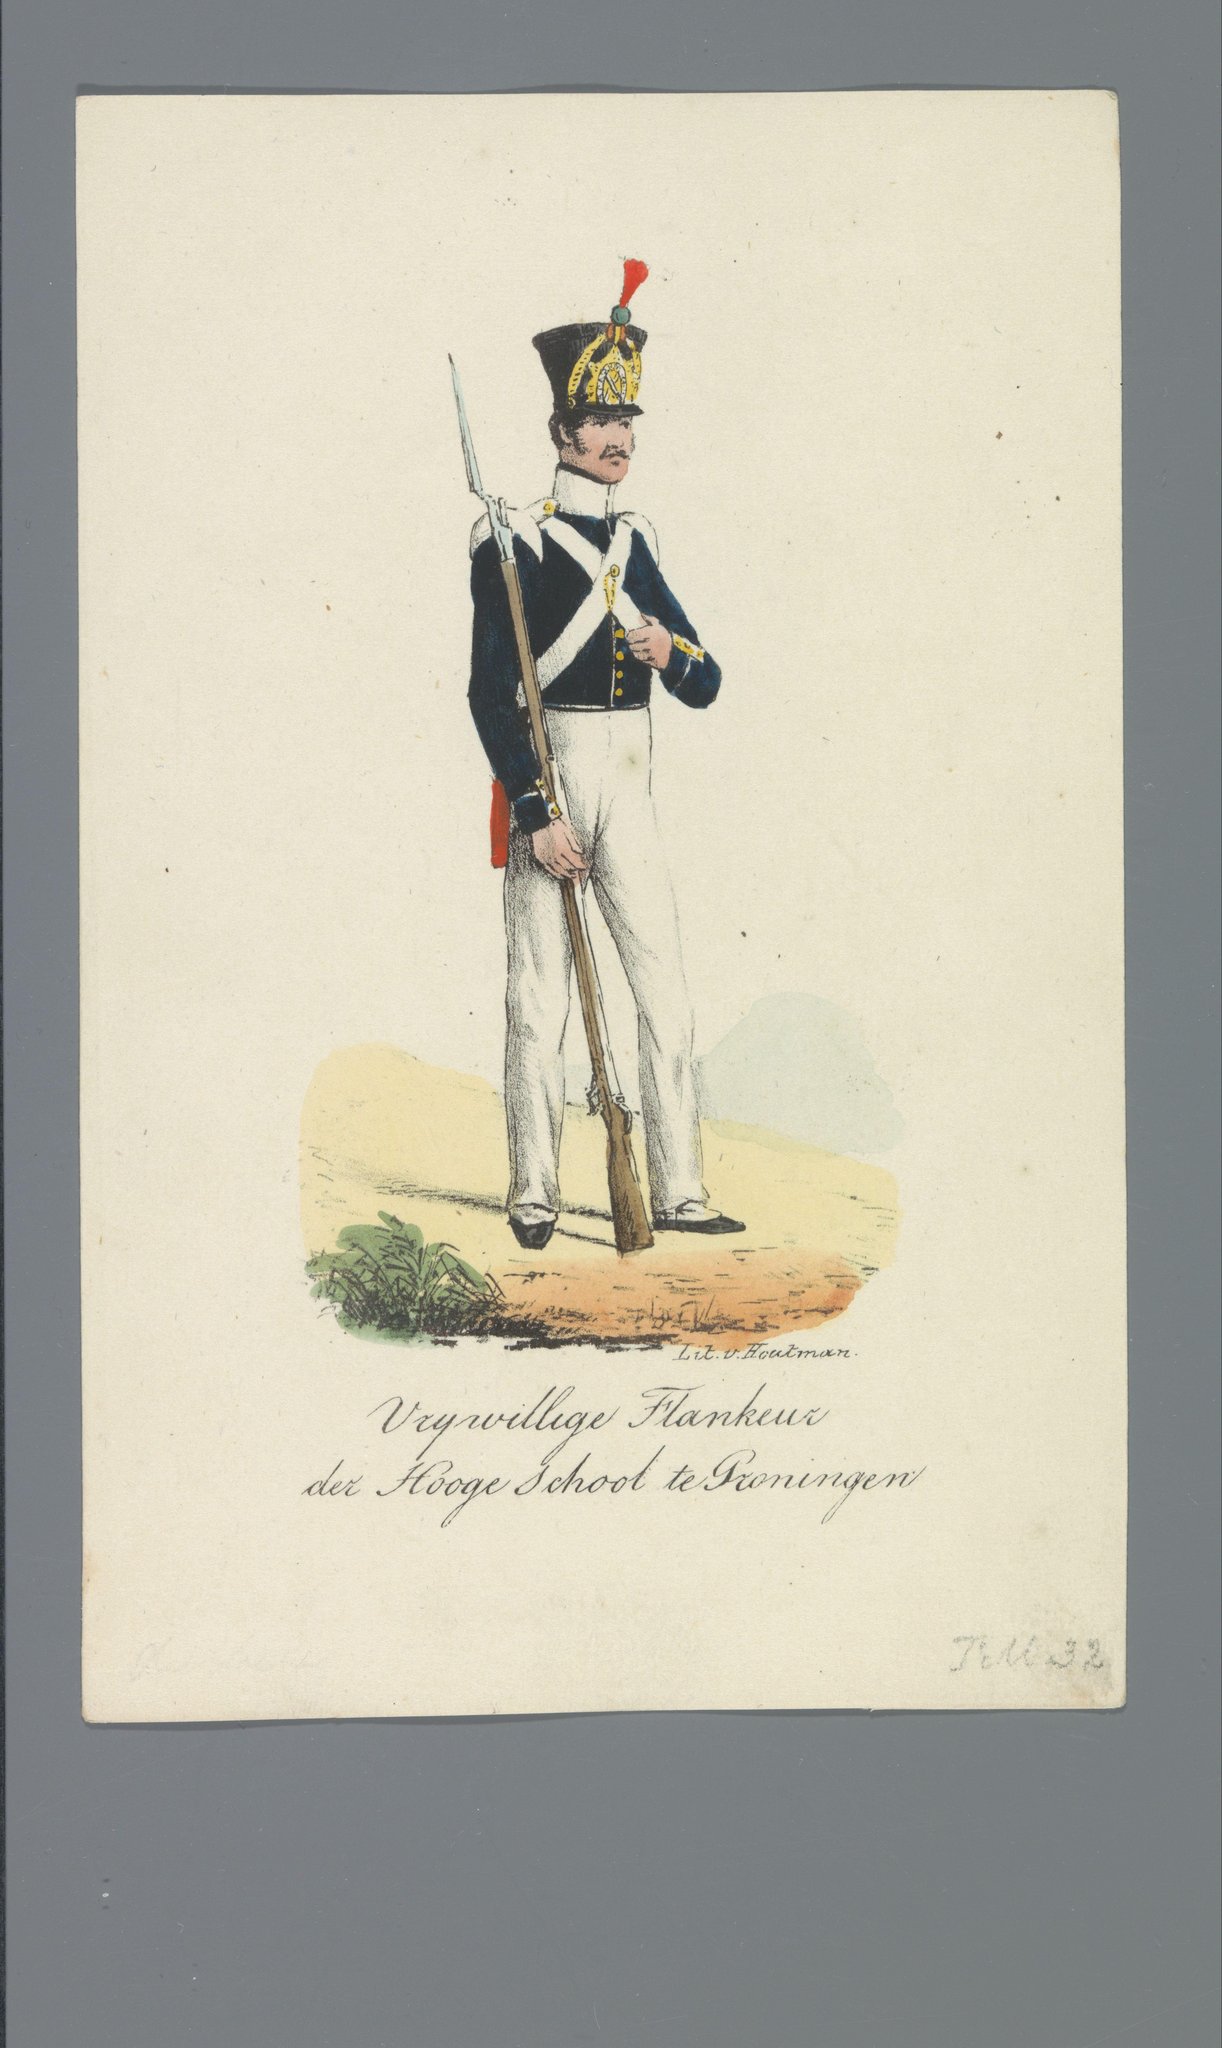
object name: costume print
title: Nederlandse militaire uniformen in de jaren 1830-1832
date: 1835-1850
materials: paper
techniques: hand coloring, lithograph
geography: utrecht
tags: (military) uniforms, clothes, costume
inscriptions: collector's mark: Lugt 2227, collector's mark: Lugt 2228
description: Staande flankeur van de Compagnie Vrijwillige Flankeurs van de Hogeschool te Groningen. Onderdeel van een serie van 157 losse bladen met Nederlandse militaire uniformen in de jaren 1830-1832.